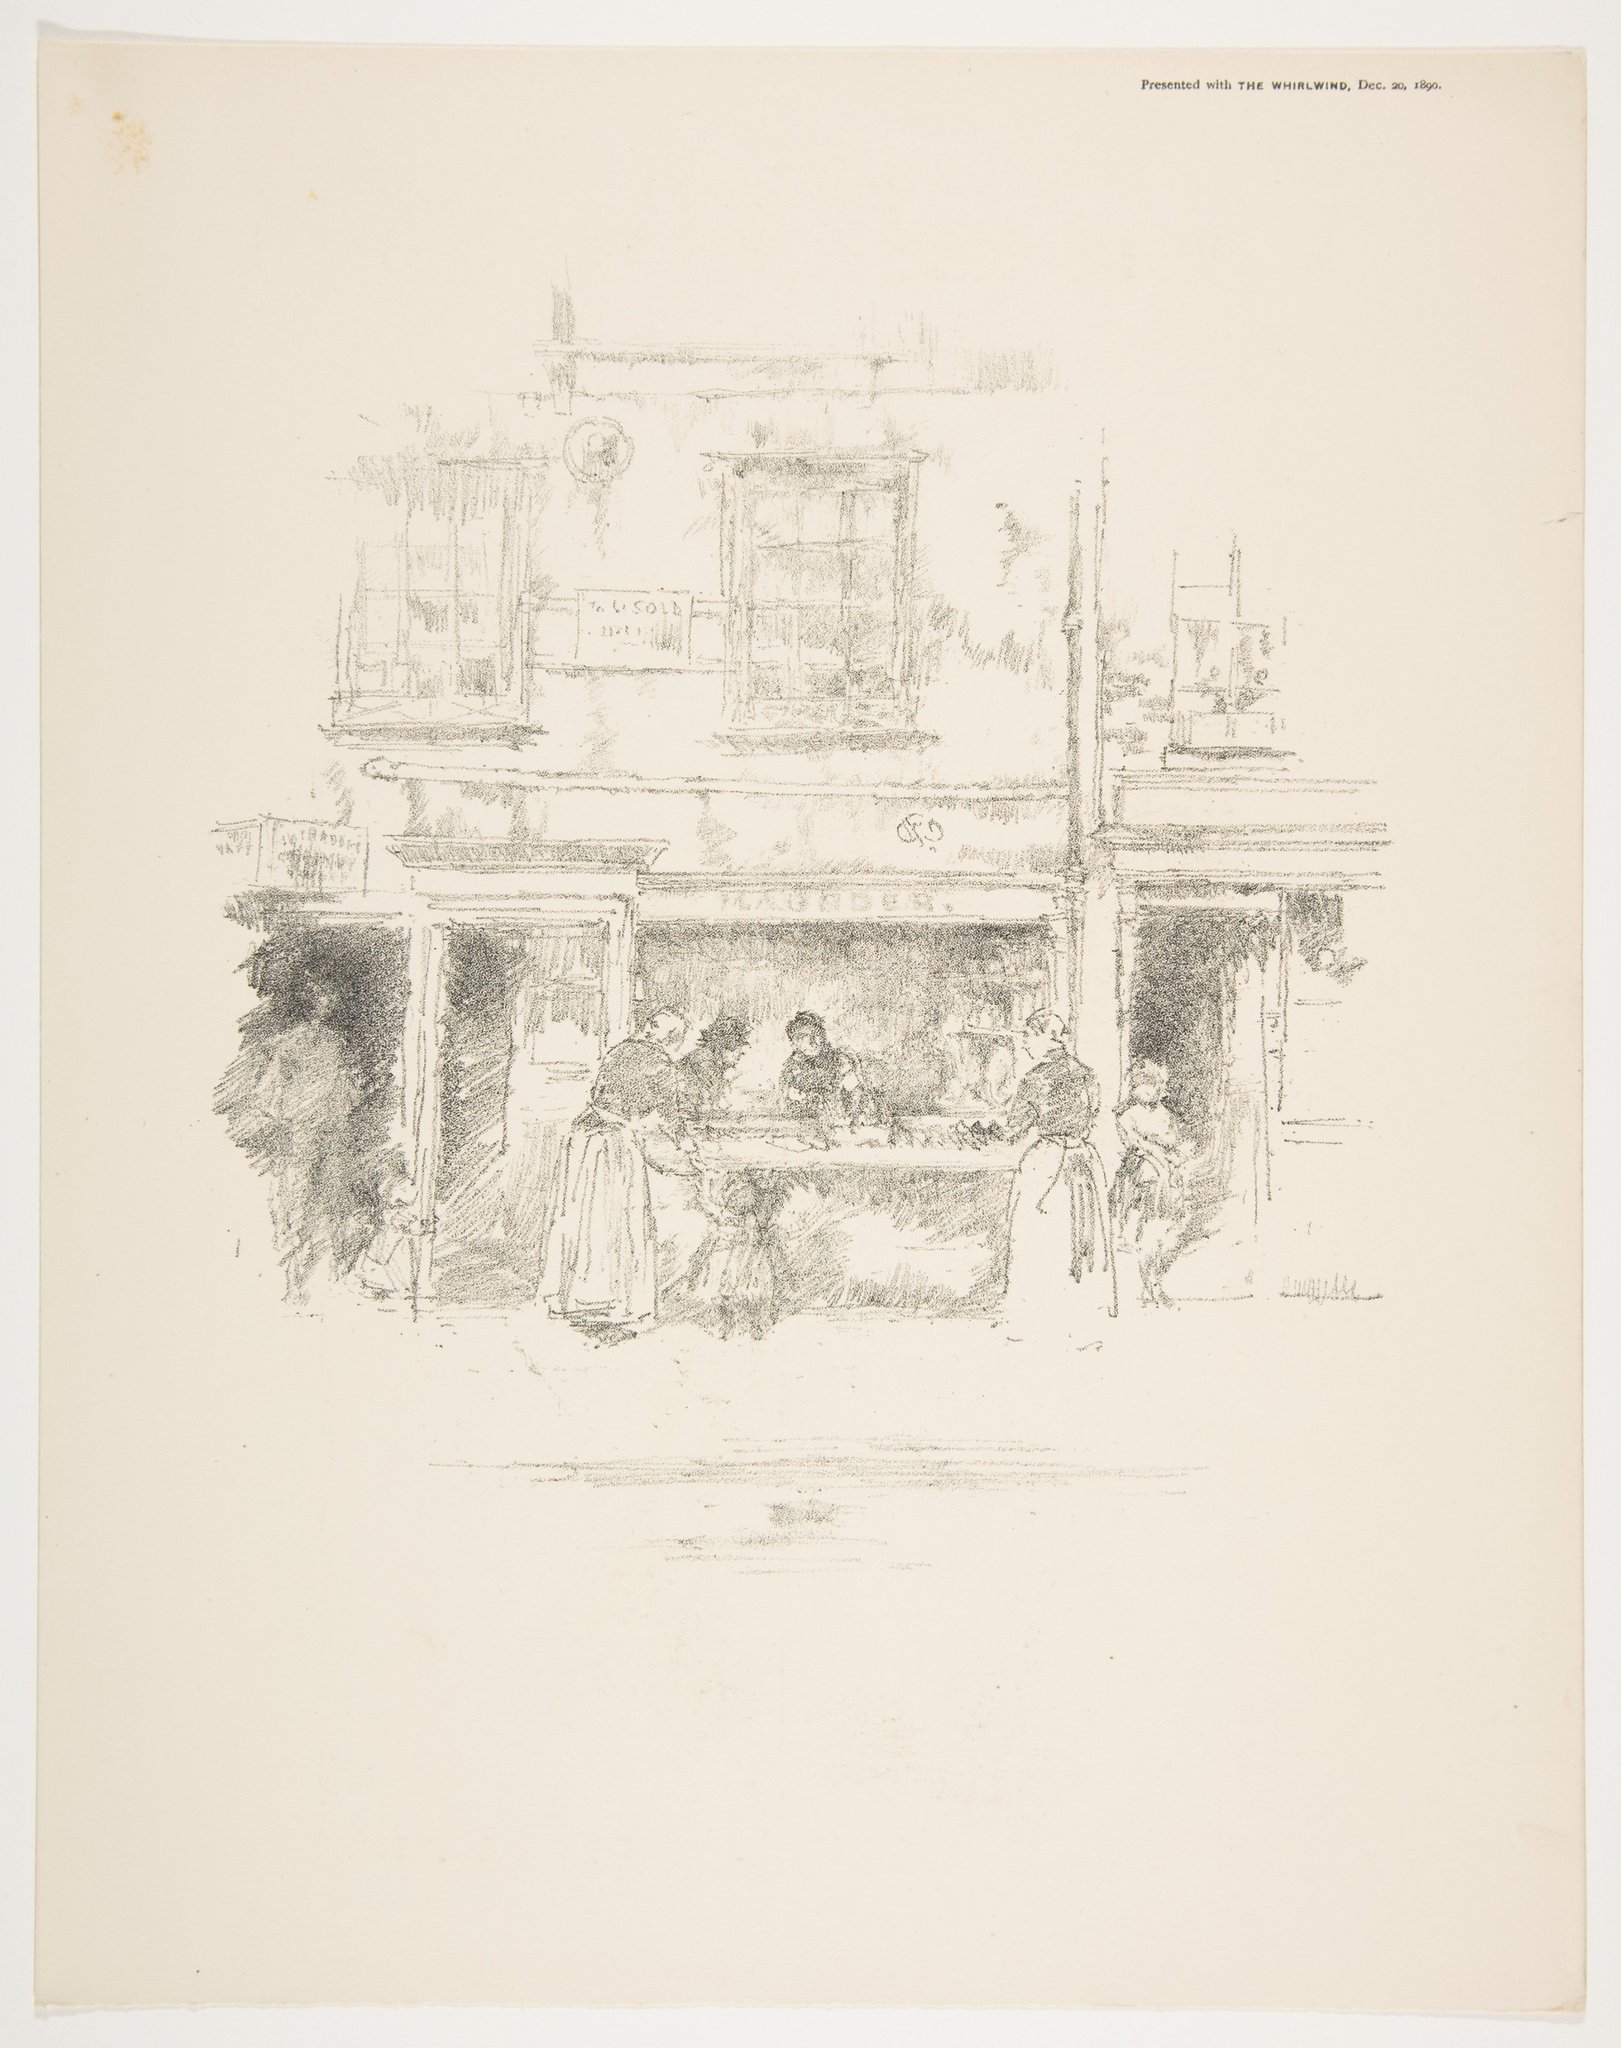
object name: print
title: Maunder's Fish Shop, Chelsea, from "Whirlwind," December 27, 1890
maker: james mcneill whistler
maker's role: artist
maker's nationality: american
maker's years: 1834-1903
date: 1890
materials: ink, paper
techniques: printing, scraping, lithography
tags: children,women